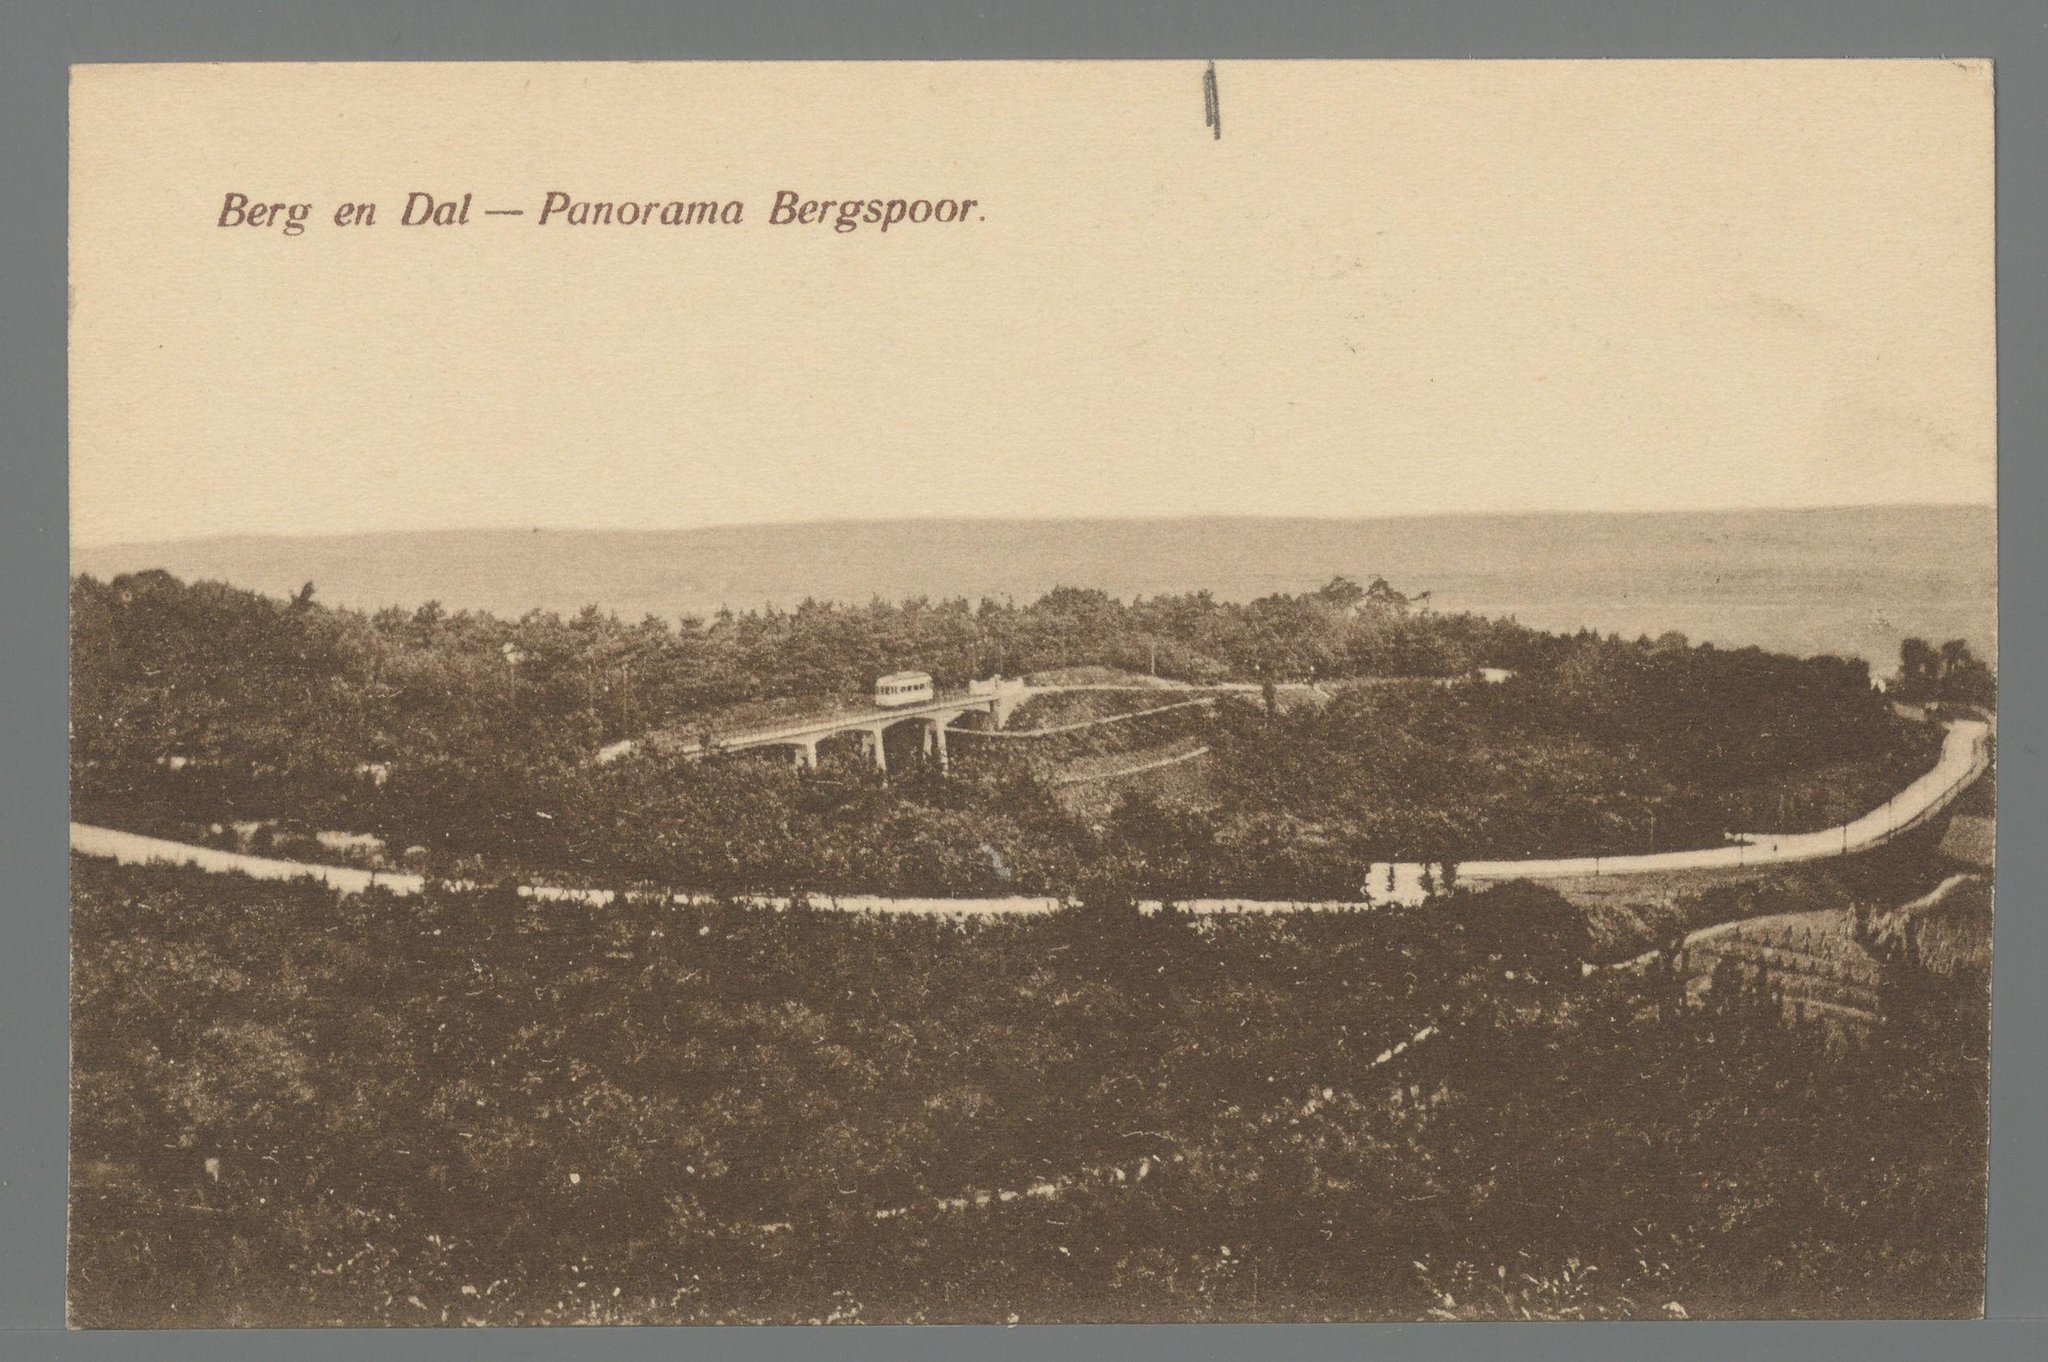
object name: ansichtkaart, prentbriefkaart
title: Berg en Dal - Panorama bergspoor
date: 1905-1930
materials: cardboard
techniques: photograph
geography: plasmolen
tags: dale, valley, tram, bridge